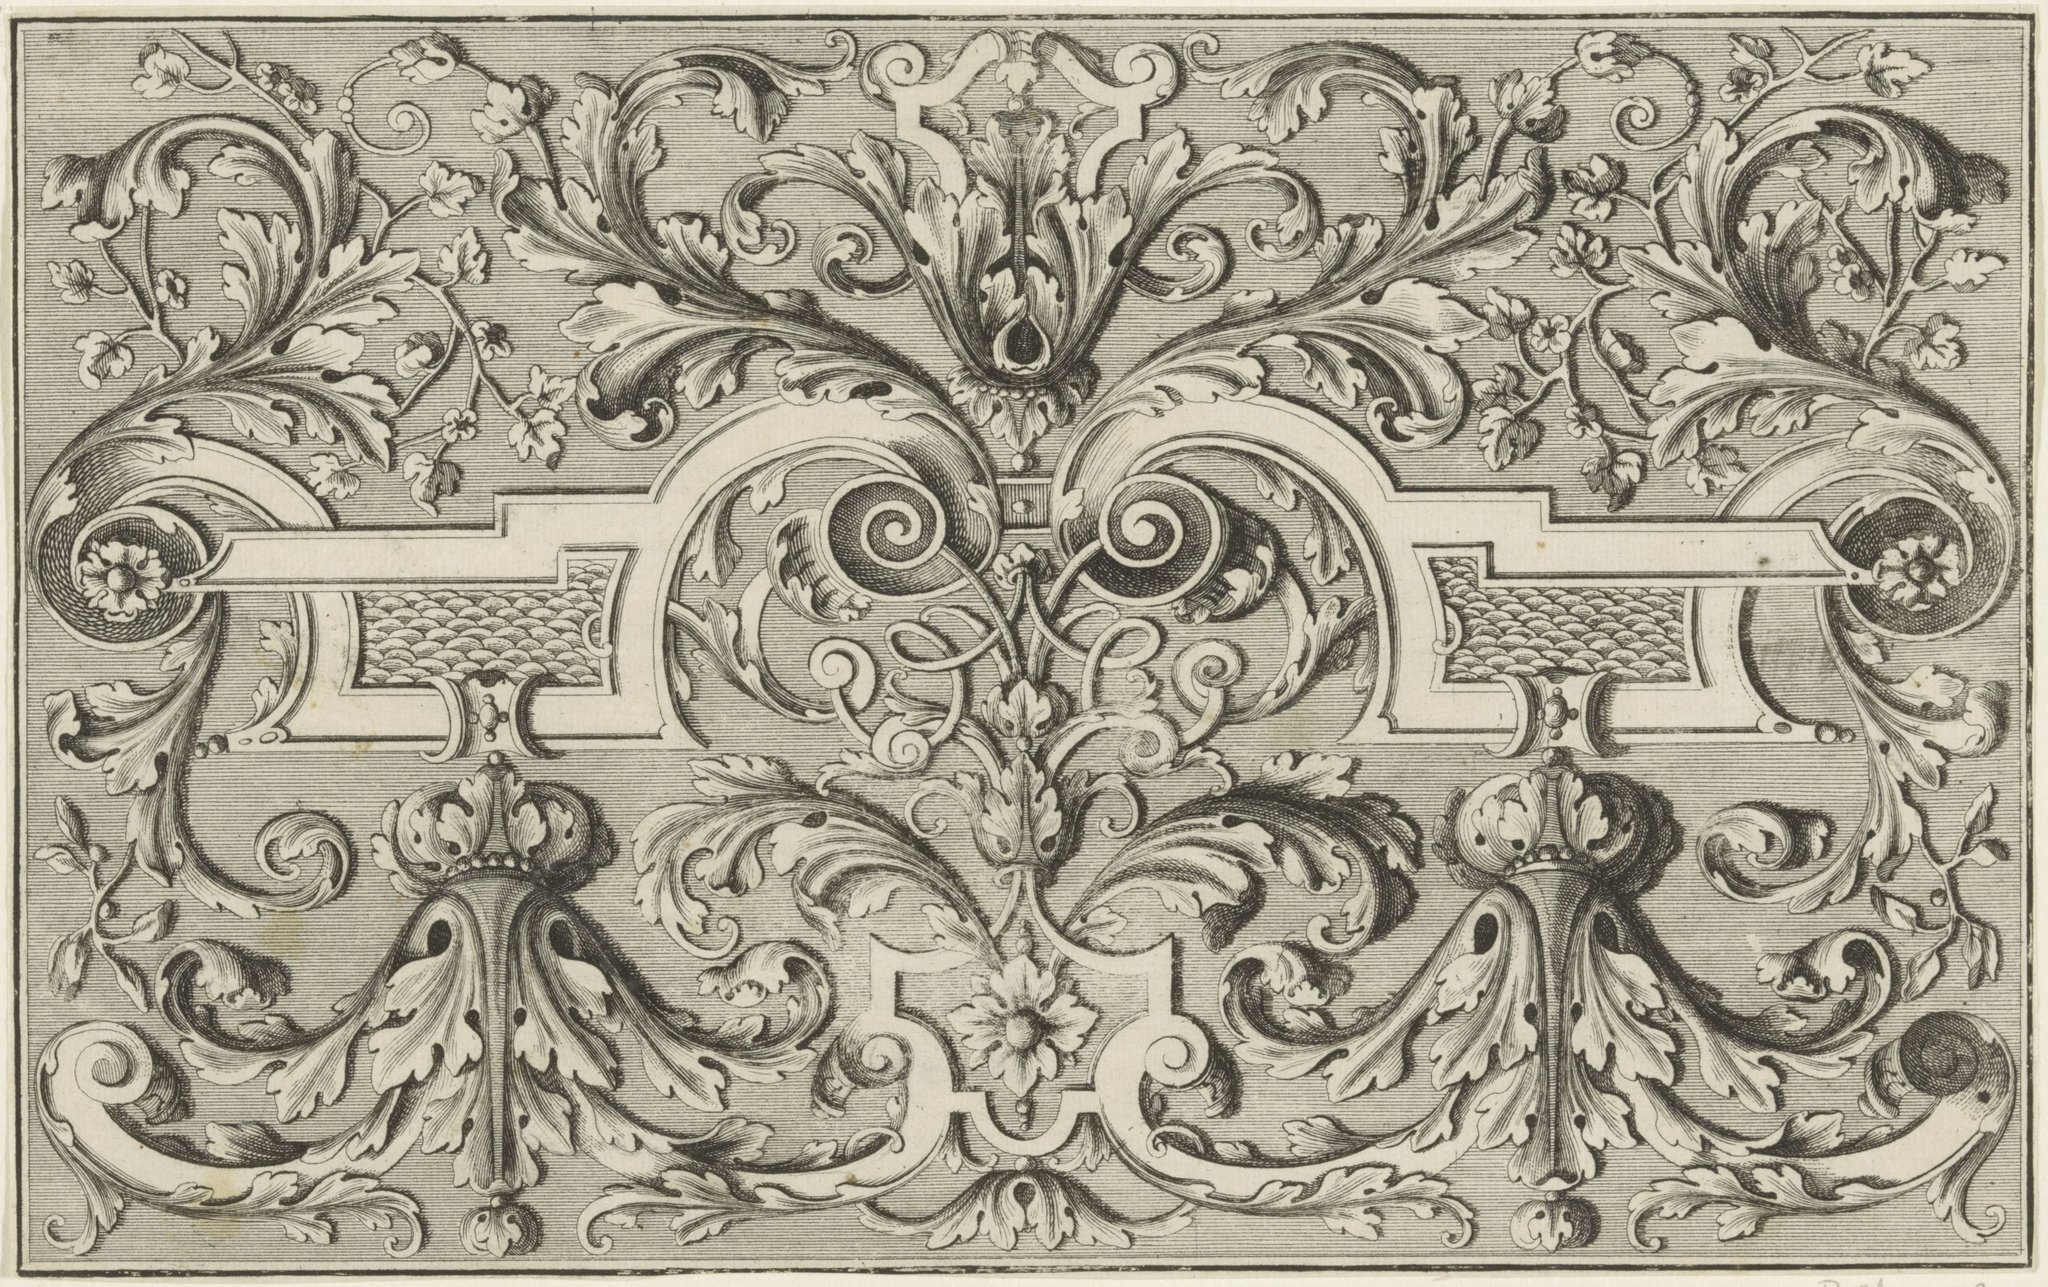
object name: print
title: Gründliche Anweisung unter schiedlicher Art Laub Werck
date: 1726-1734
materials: paper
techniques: etching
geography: nuremberg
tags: ornament ~ arabesque, 'laub- und bandelwerk' ~ ornament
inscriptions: collector's mark: Lugt 2228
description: Arabesken met bladeren, bloemen en vlechtwerk links en rechts van het midden.